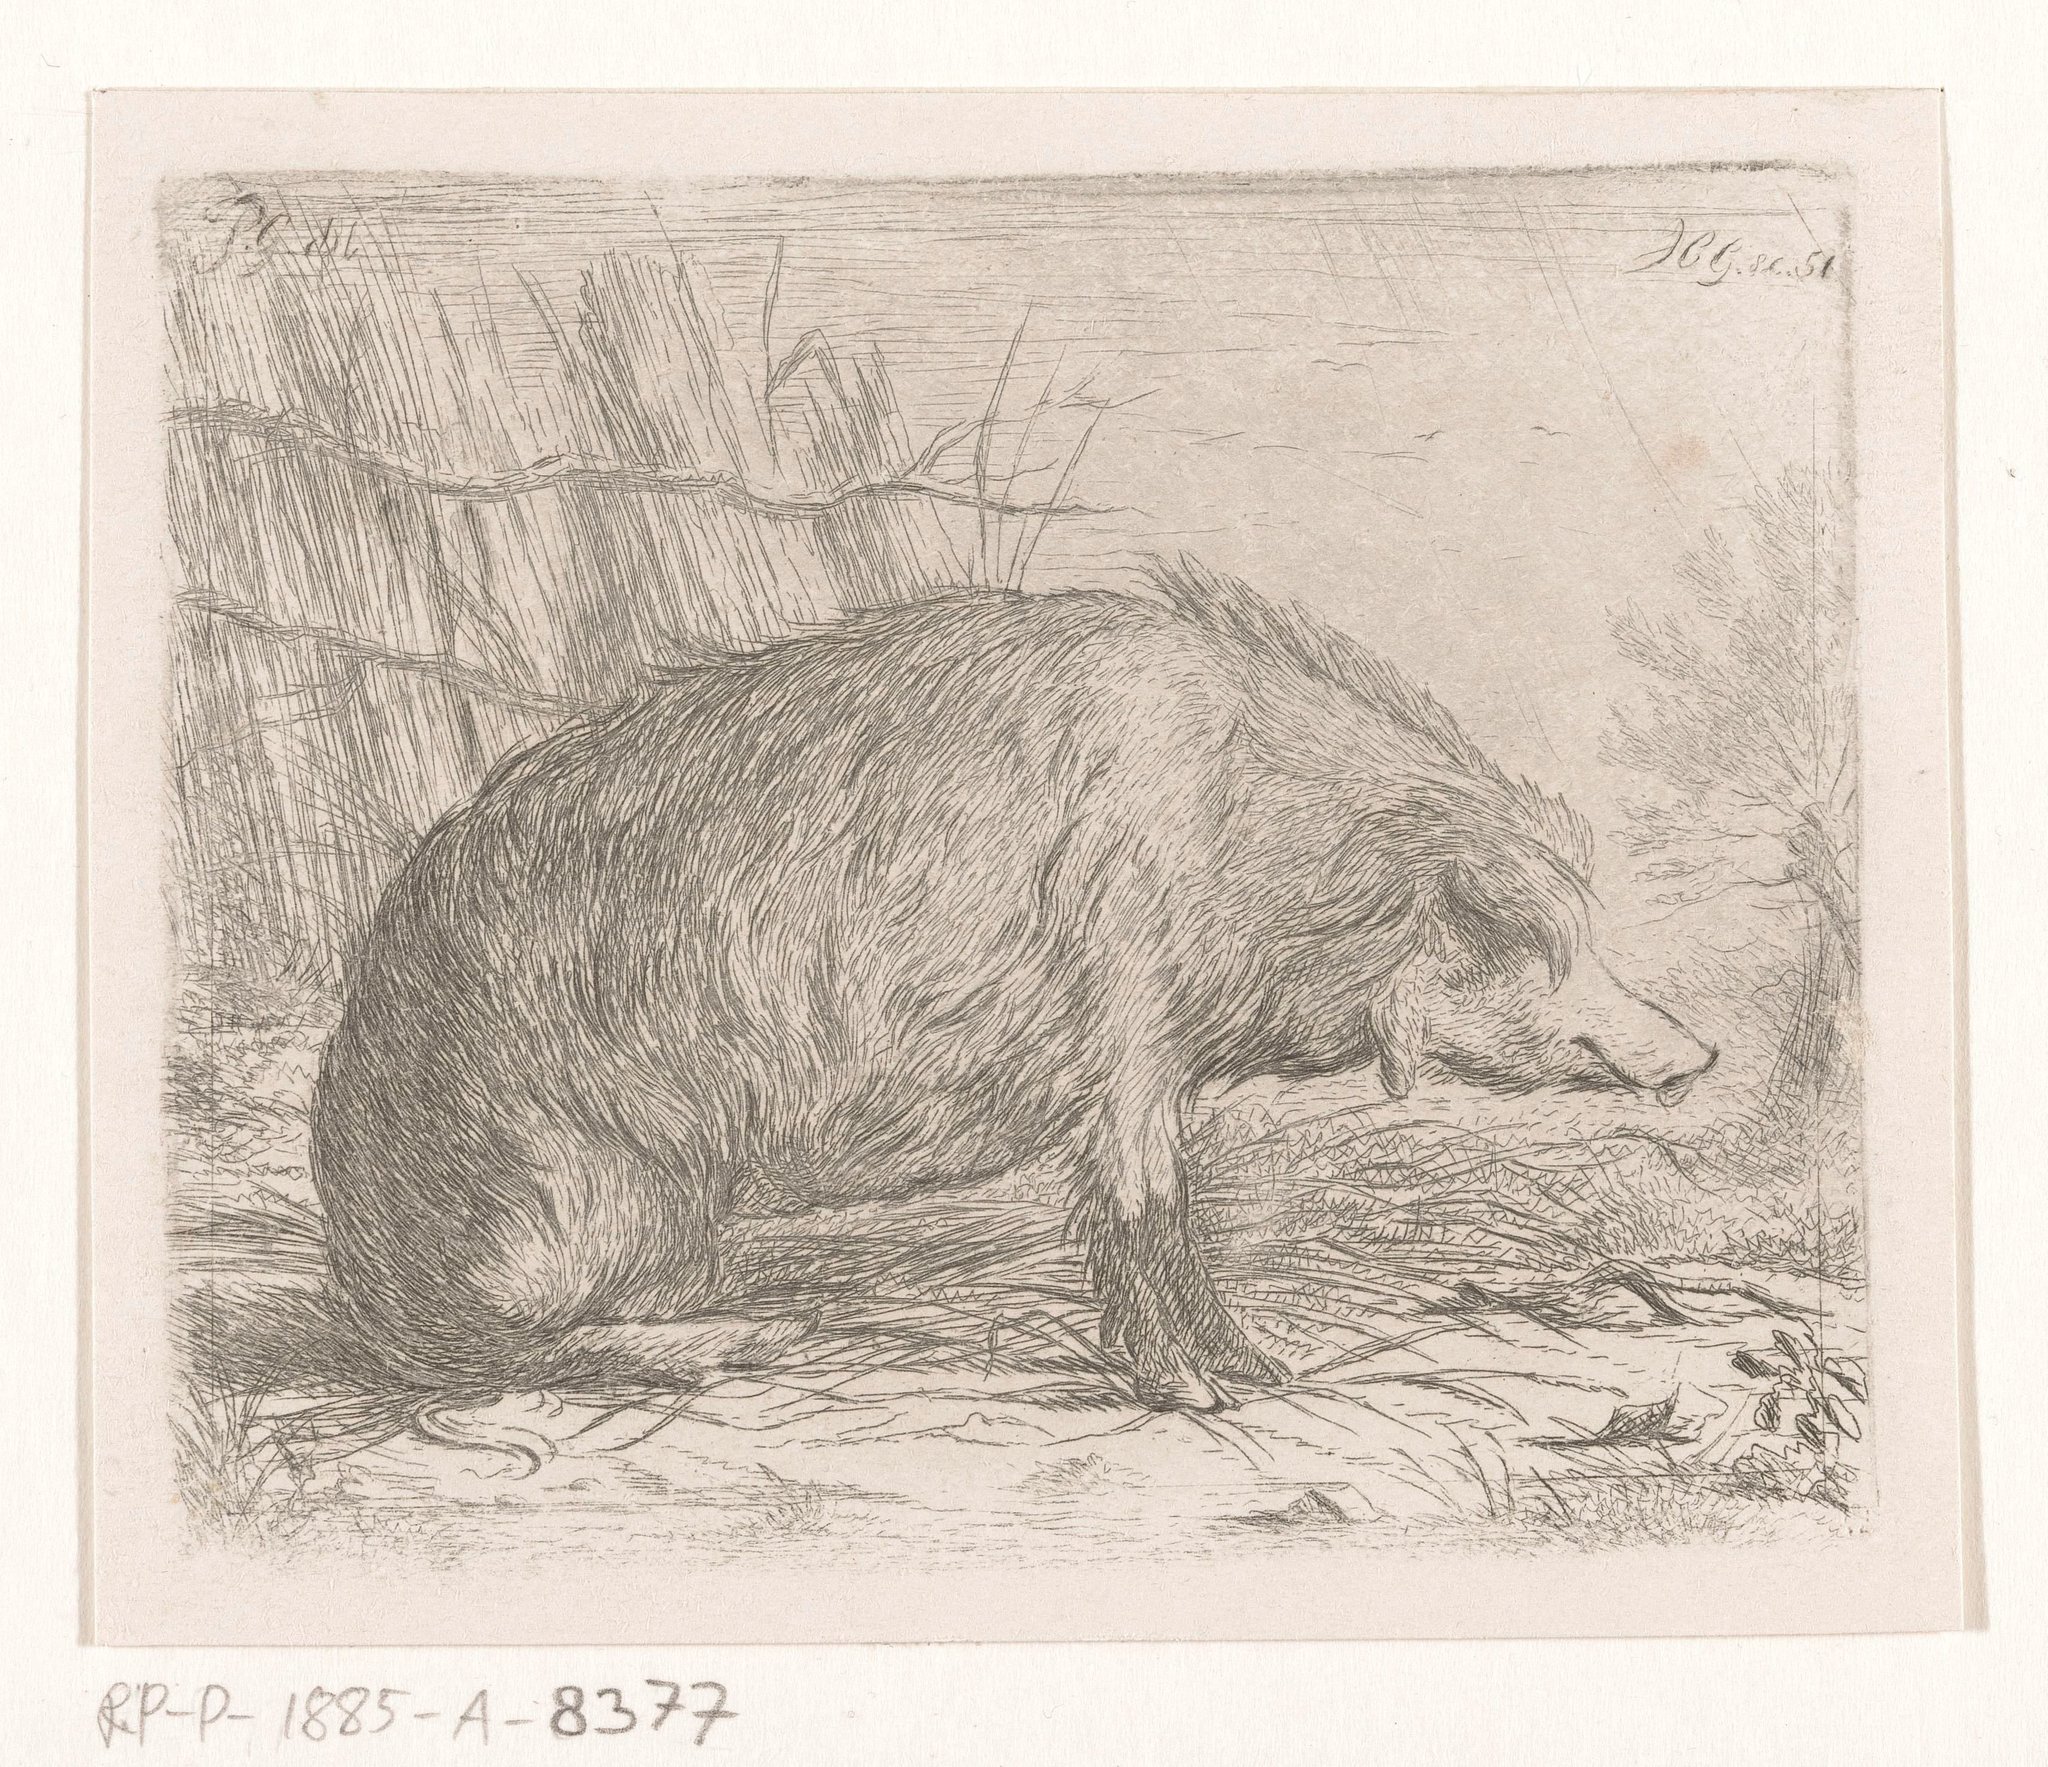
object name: print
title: Zittend everzwijn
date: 1851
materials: paper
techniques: etching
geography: the hague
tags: pig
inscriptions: collector's mark: Lugt 2228